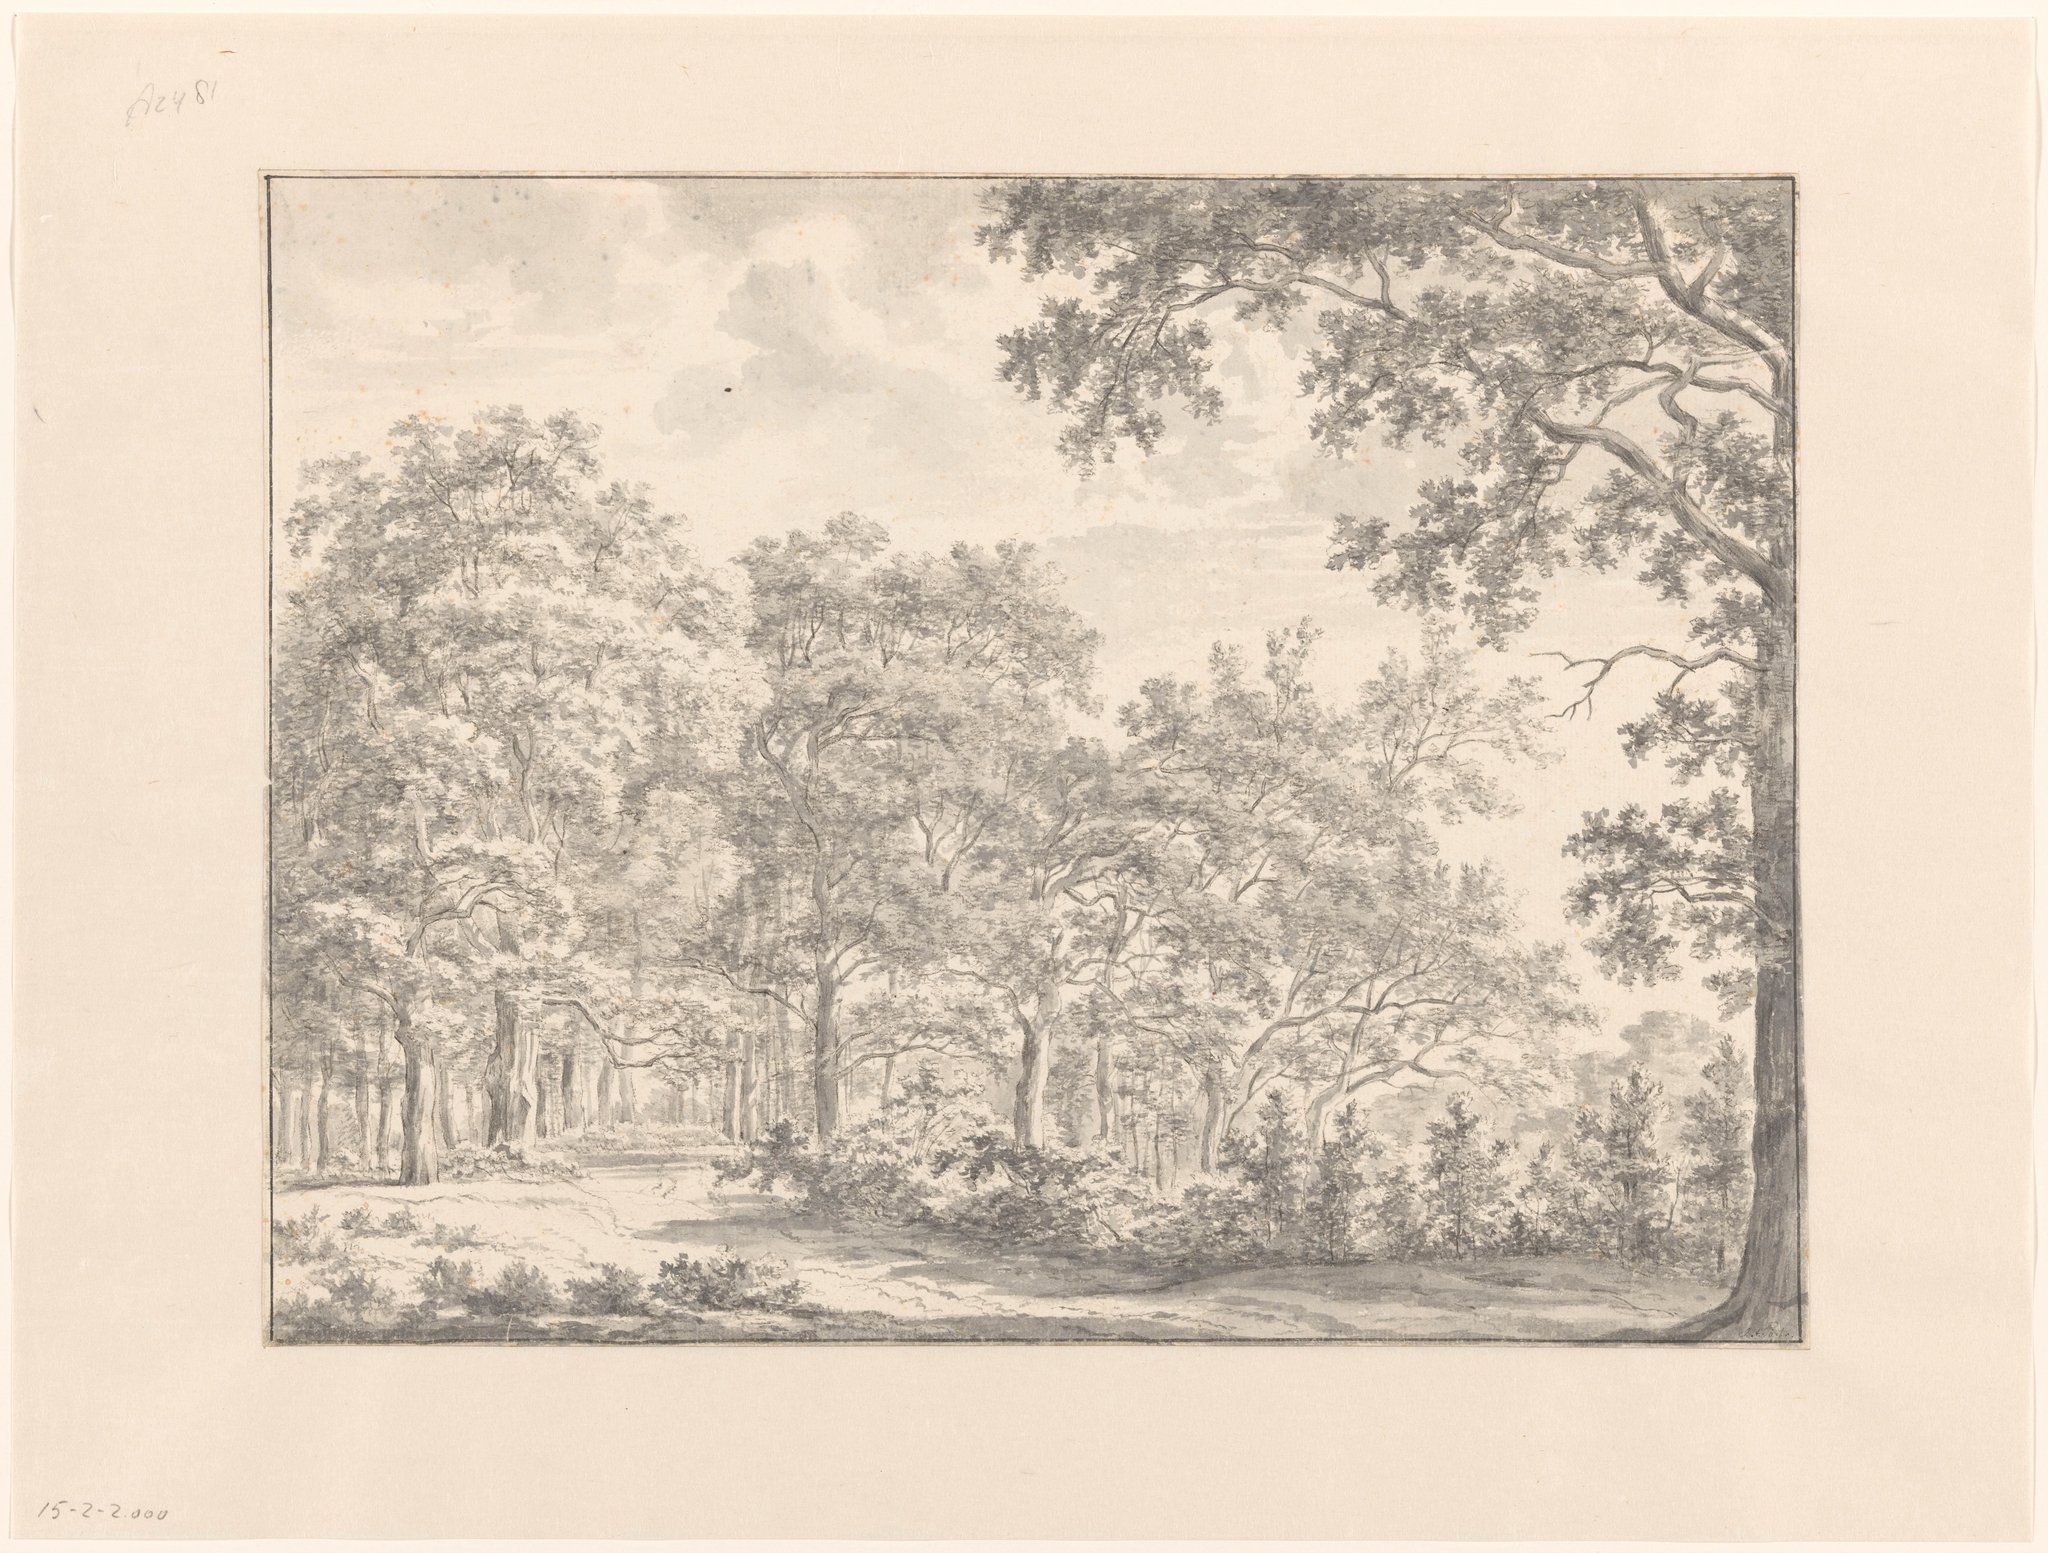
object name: drawing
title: Bosgezicht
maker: jan andries töpfer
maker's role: draughtsman, print maker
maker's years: 1792-1841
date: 1802-1841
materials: chalk, paper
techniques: brush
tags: forest, wood